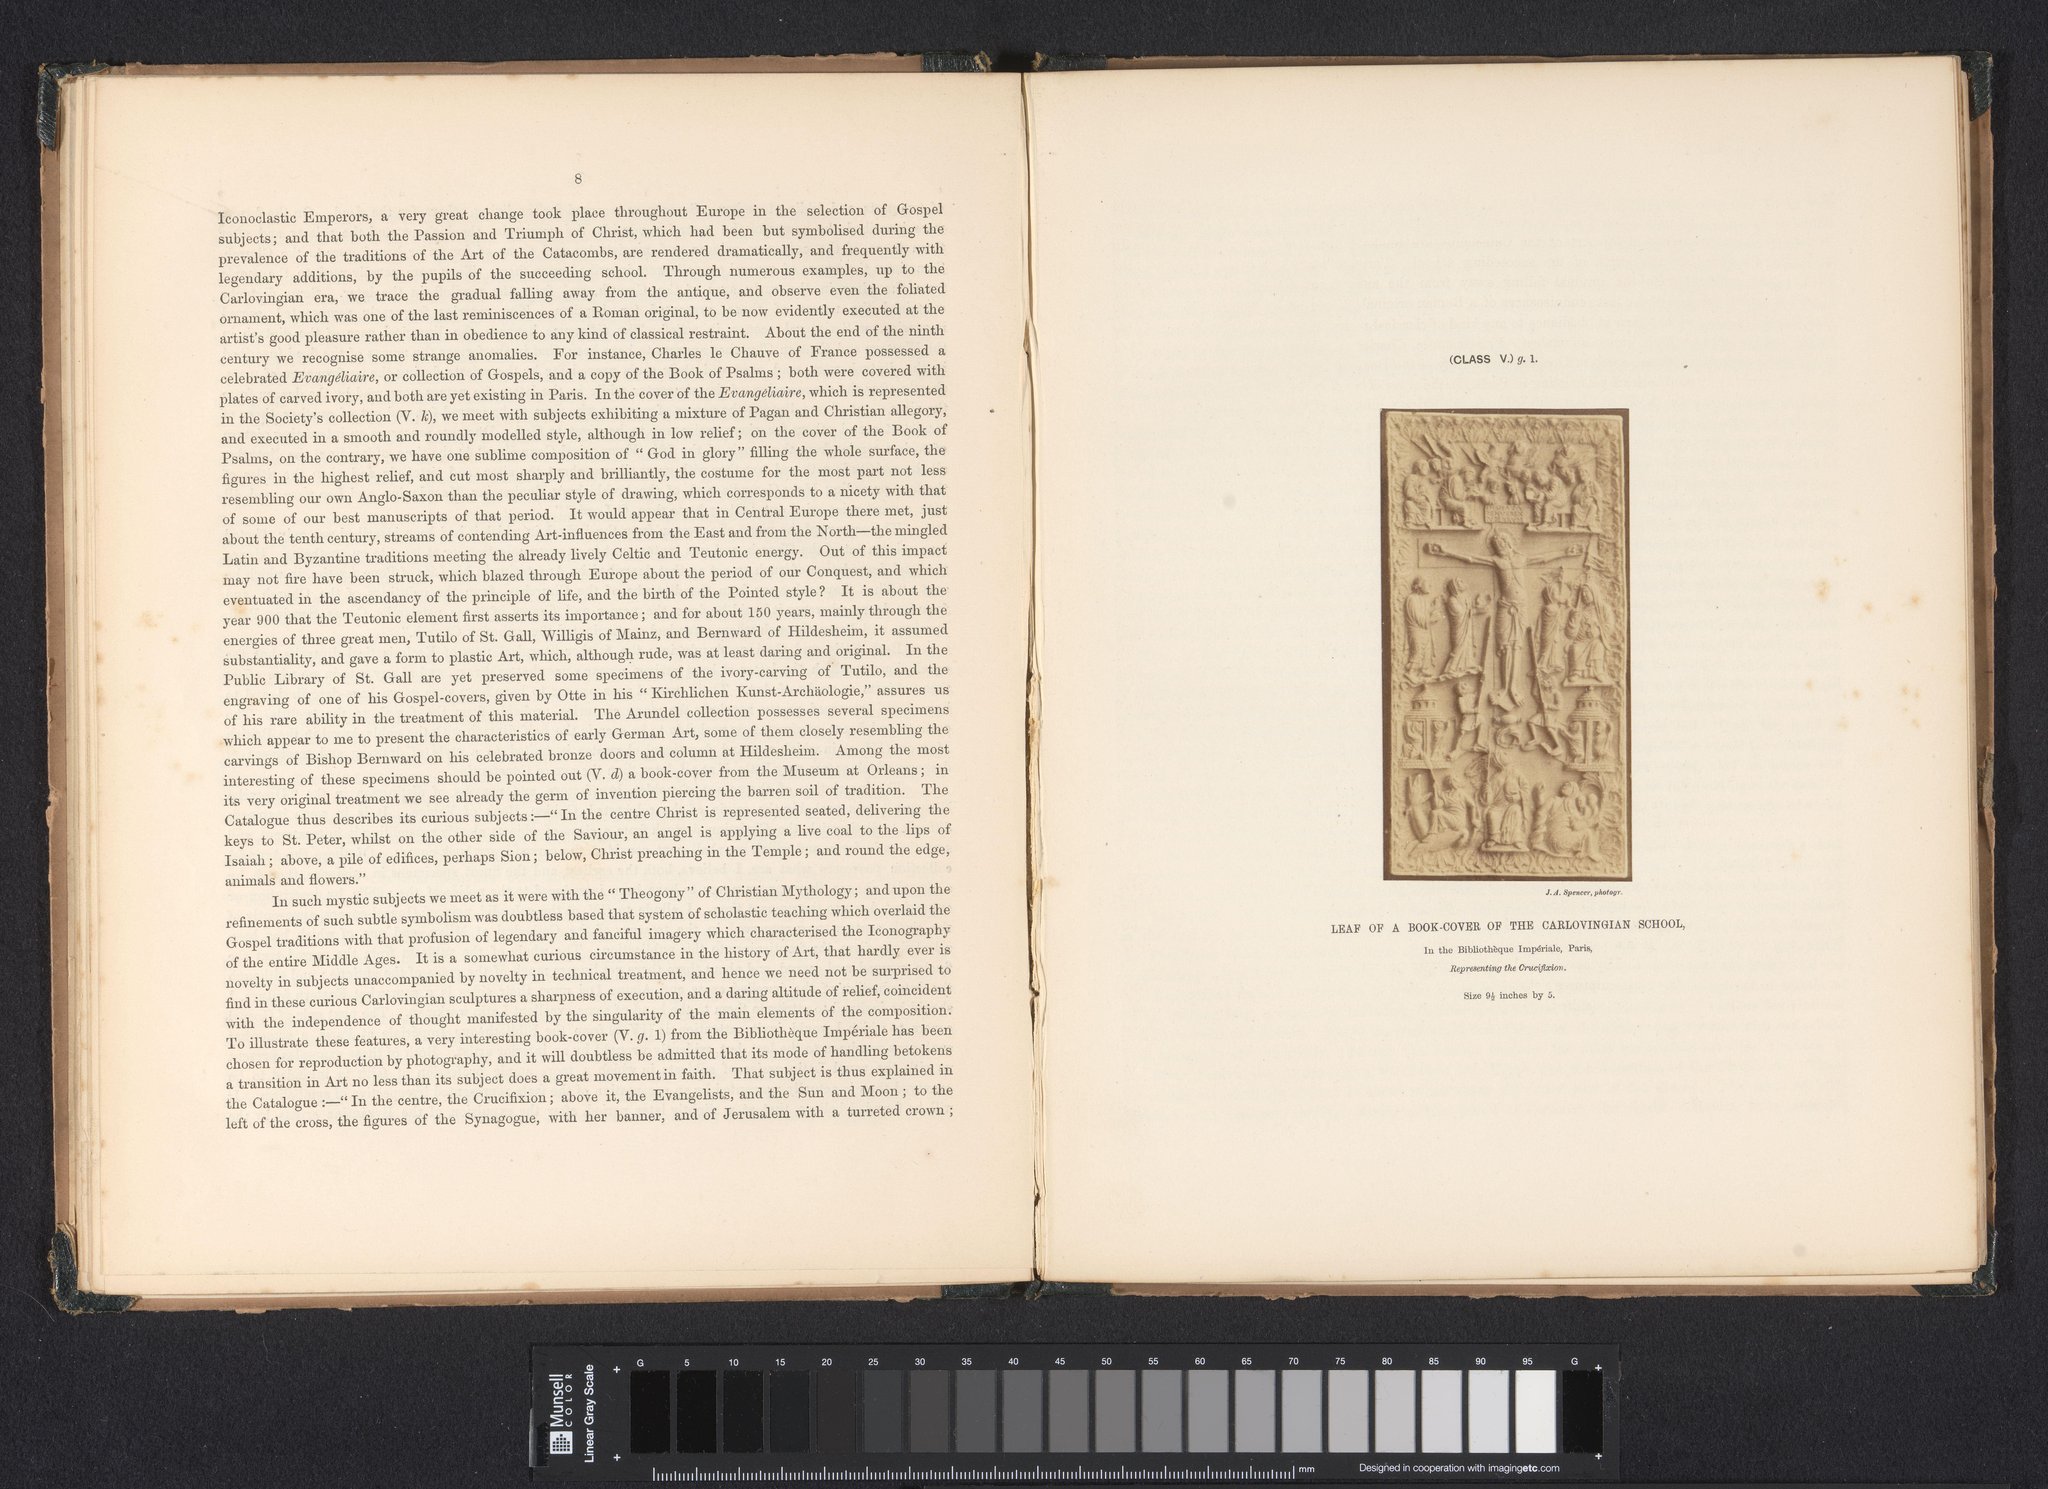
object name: page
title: Leaf of a book-cover of the Carlovingian school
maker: j.a. spencer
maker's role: fotograaf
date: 1850-1856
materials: photographic support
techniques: albumen print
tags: book-cover, binding, the crucifixion of christ: christ's death on the cross; golgotha (matthew 27:45-58; mark 15:33-45; luke 23:44-52; john 19:25-38)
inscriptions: inscription: ‘In the Bibliothèque Impérials, Paris, Representing the Crucifixion. Size 9.5 inches by 5.’, number: ‘(Class V.) g.1.’